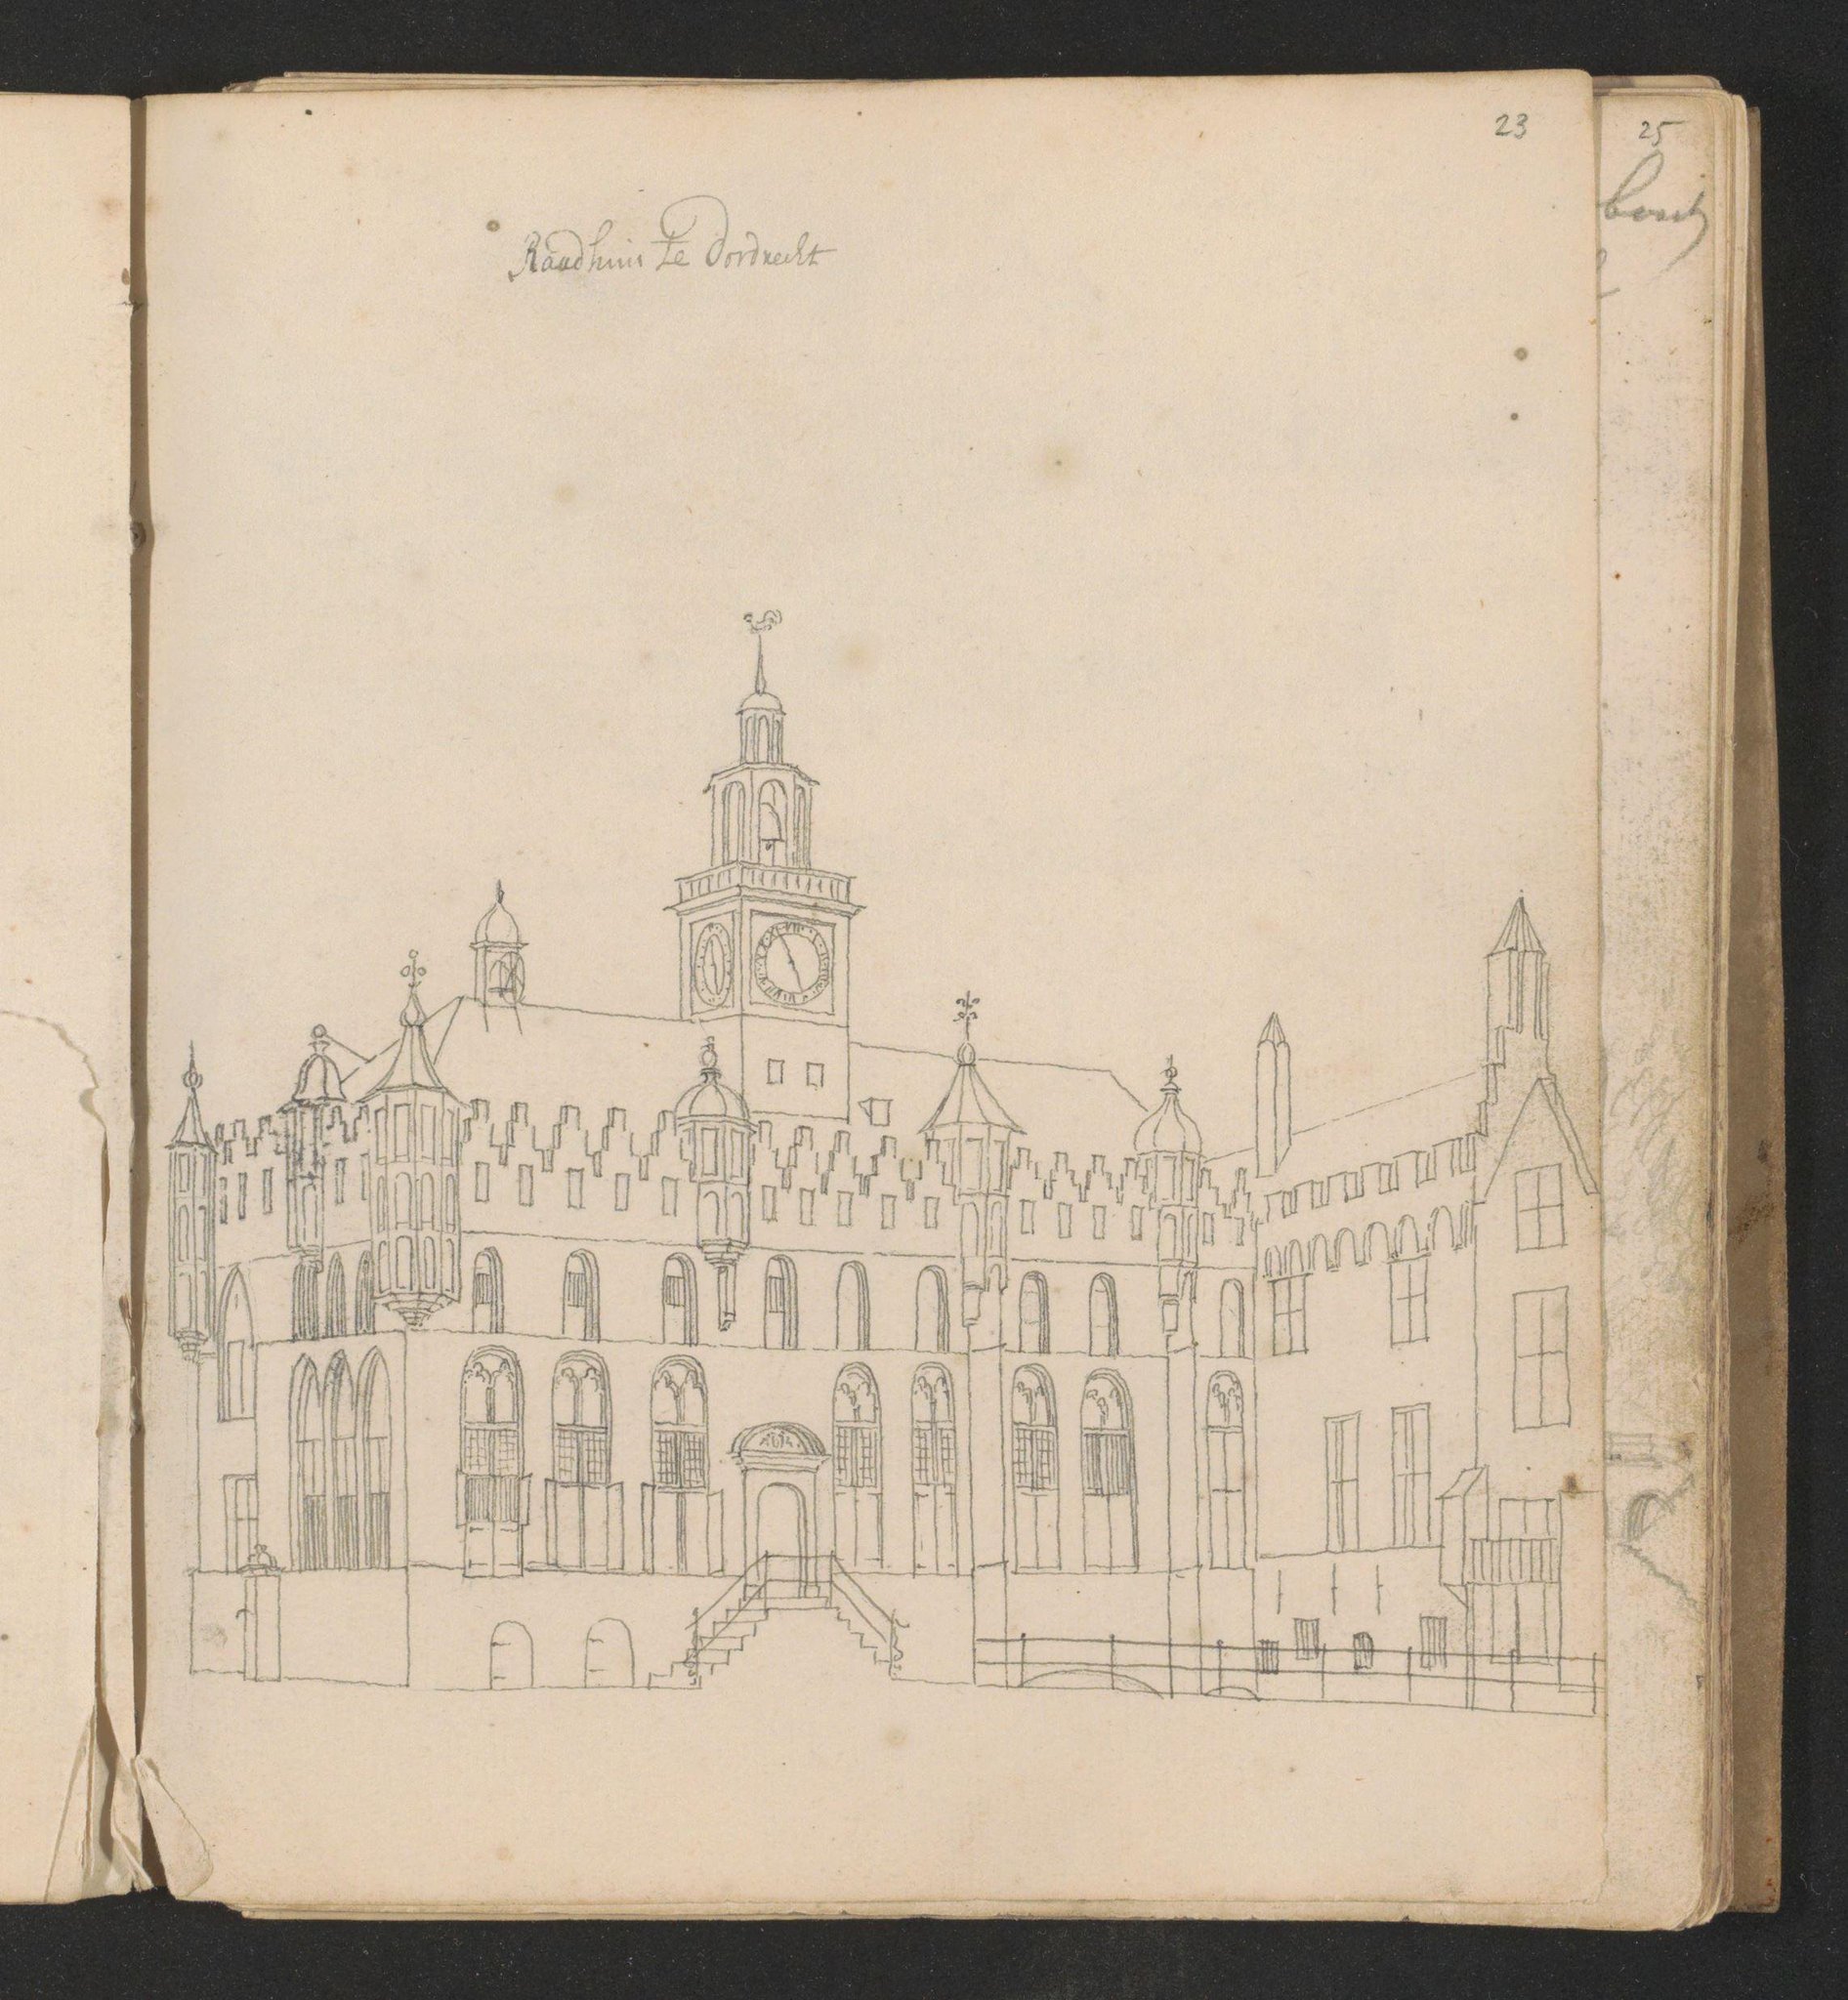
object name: sketchbook leaf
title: Raadhuis te Dordrecht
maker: cornelis pronk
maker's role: draughtsman, painter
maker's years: 1691-1759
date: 1728-1732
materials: ink, paper, pencil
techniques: pen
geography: dordrecht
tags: townhall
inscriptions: annotation: ‘Raadhuis te Dordrecht’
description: Bladzijde 23 uit een schetsboek met 96 bladzijden.